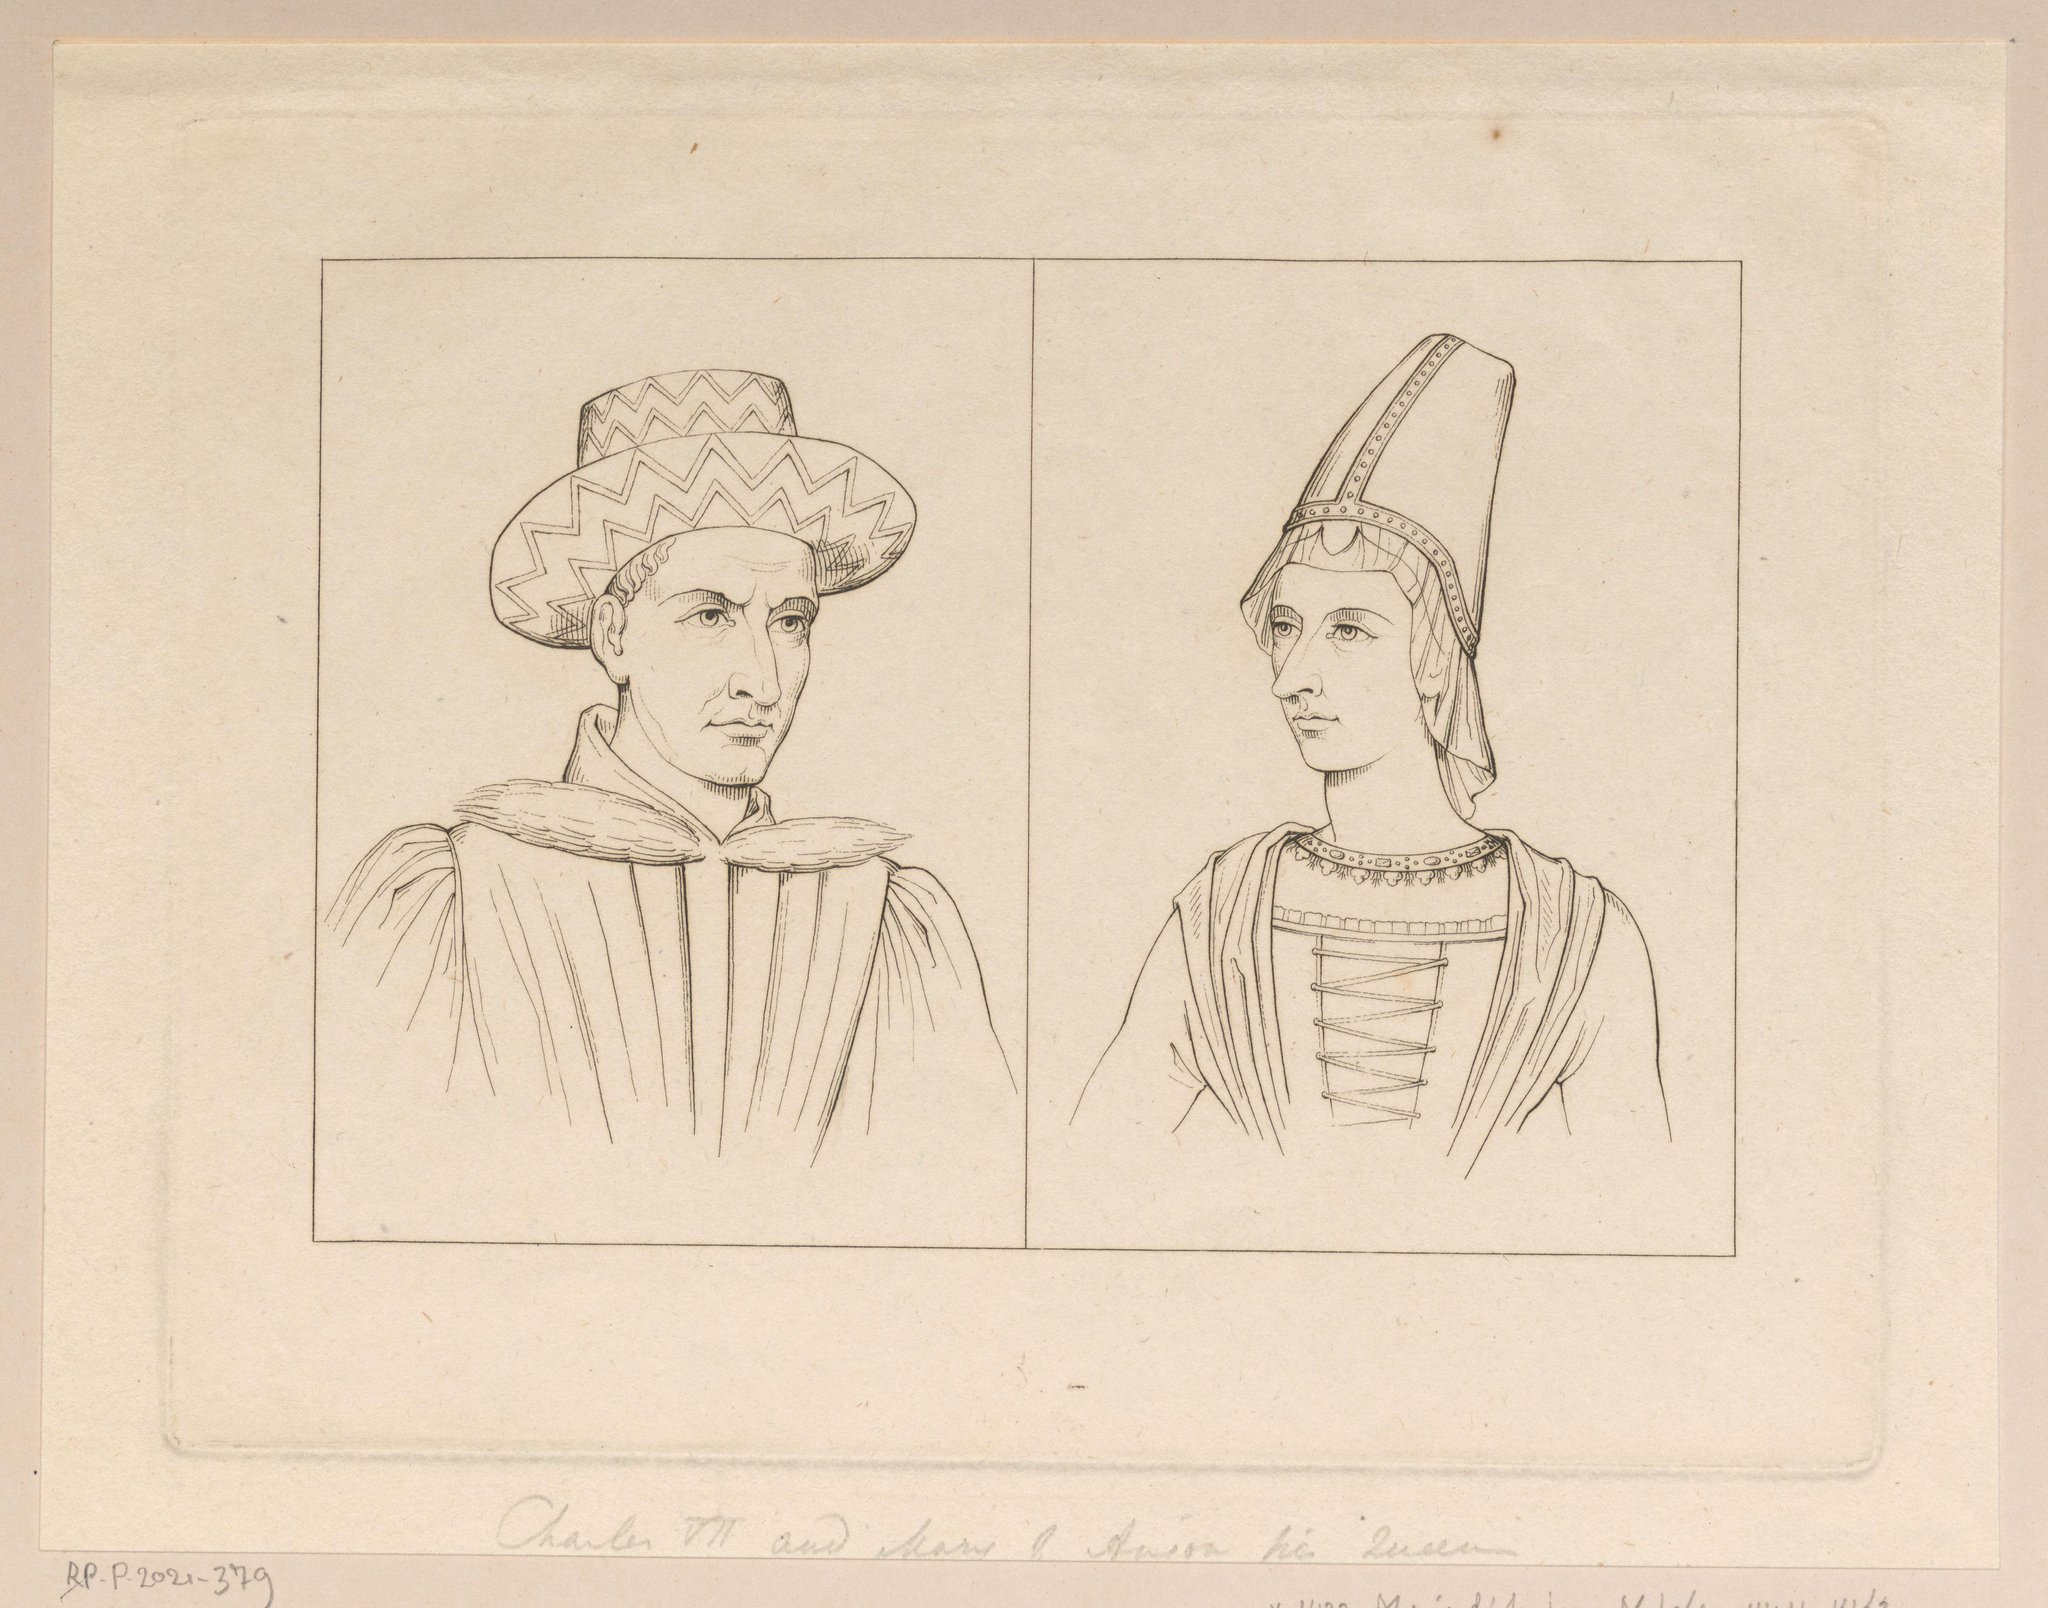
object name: print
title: Portret van Karel VII, koning van Frankrijk en Maria van Anjou, koningin van Frankrijk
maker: Anonymous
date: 1800-1874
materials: paper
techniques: engraving, etching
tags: paris, france, historical persons - bb - woman, historical persons, queen, king